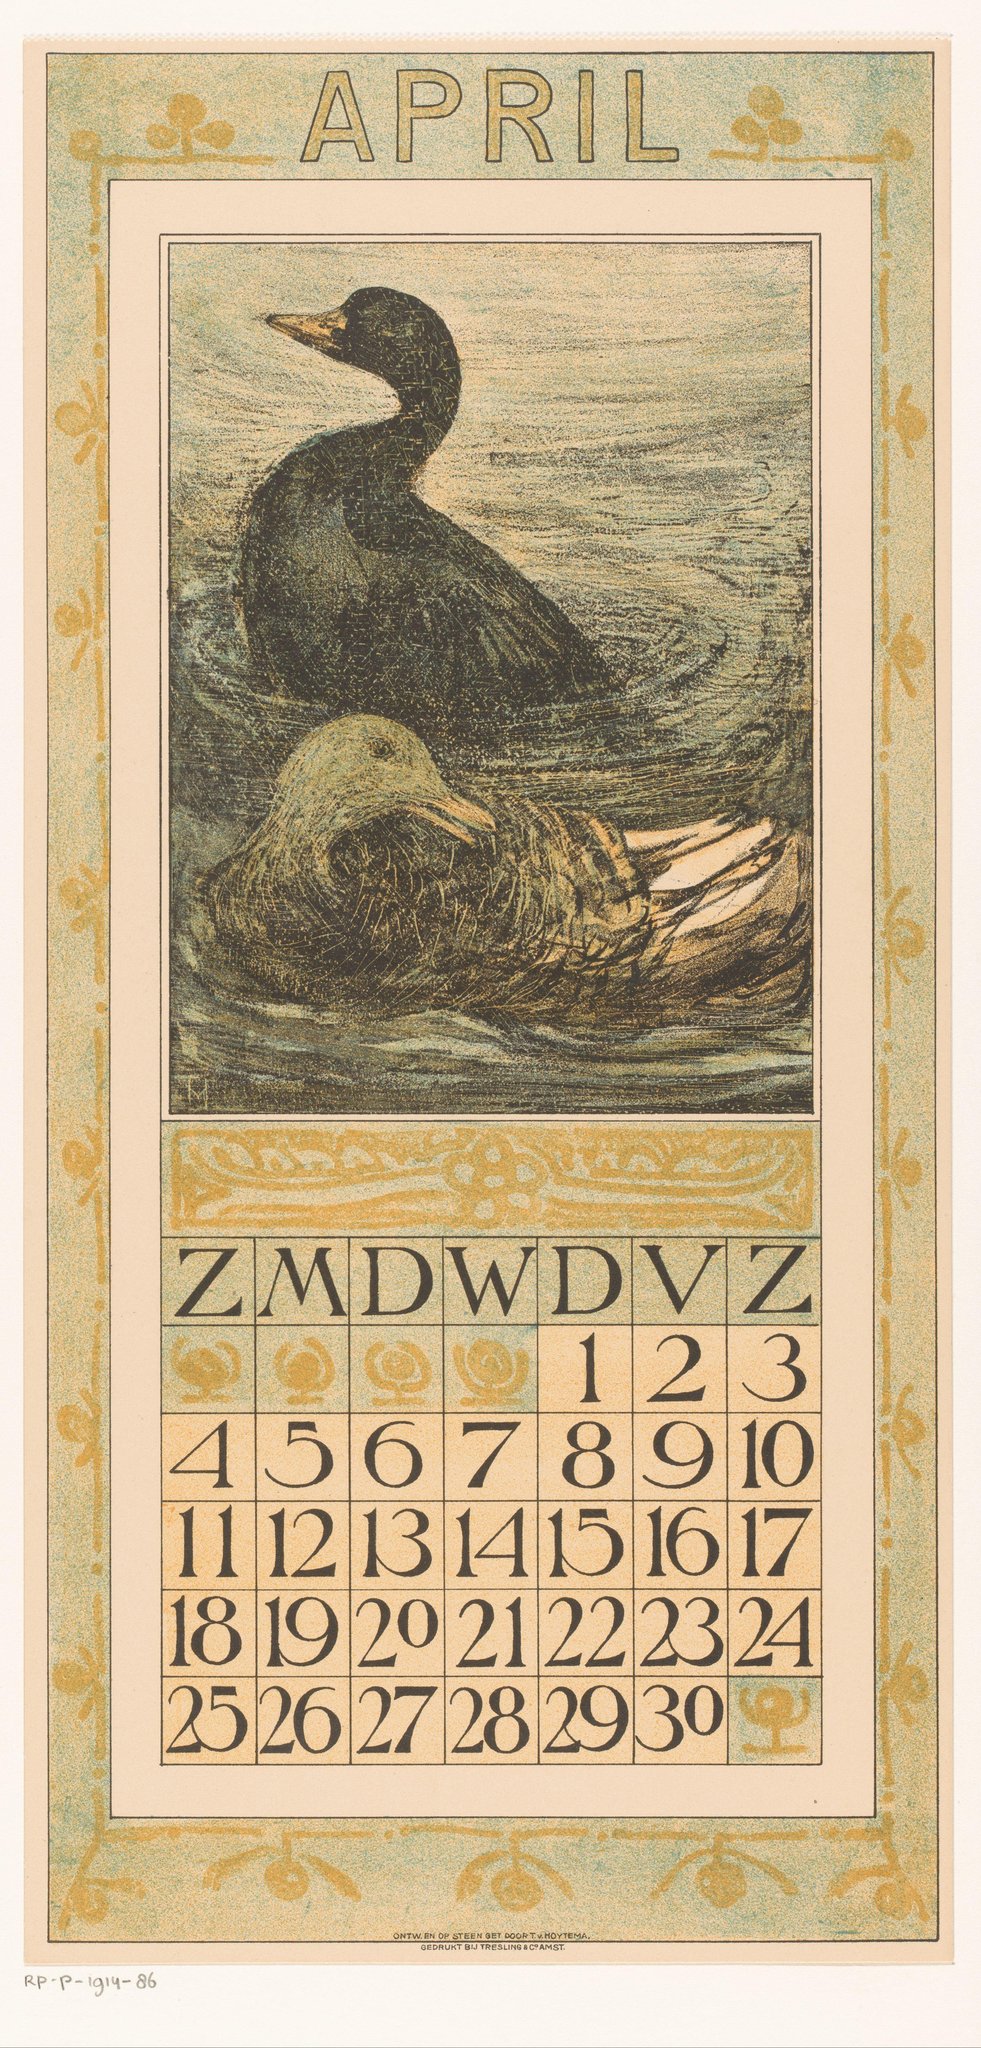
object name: calendar leaf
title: Kalender 1909 12 lithografien door Th. v. Hoytema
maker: theo van hoytema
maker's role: draughtsman, painter, print maker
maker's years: 1863-1917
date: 1908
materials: paper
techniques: lithograph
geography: the hague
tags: water-birds: duck, april ~ other concepts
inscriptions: collector's mark: Lugt 2228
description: De zwarte eend rijst op uit het water. Bovenaan het blad een scheurlijn.